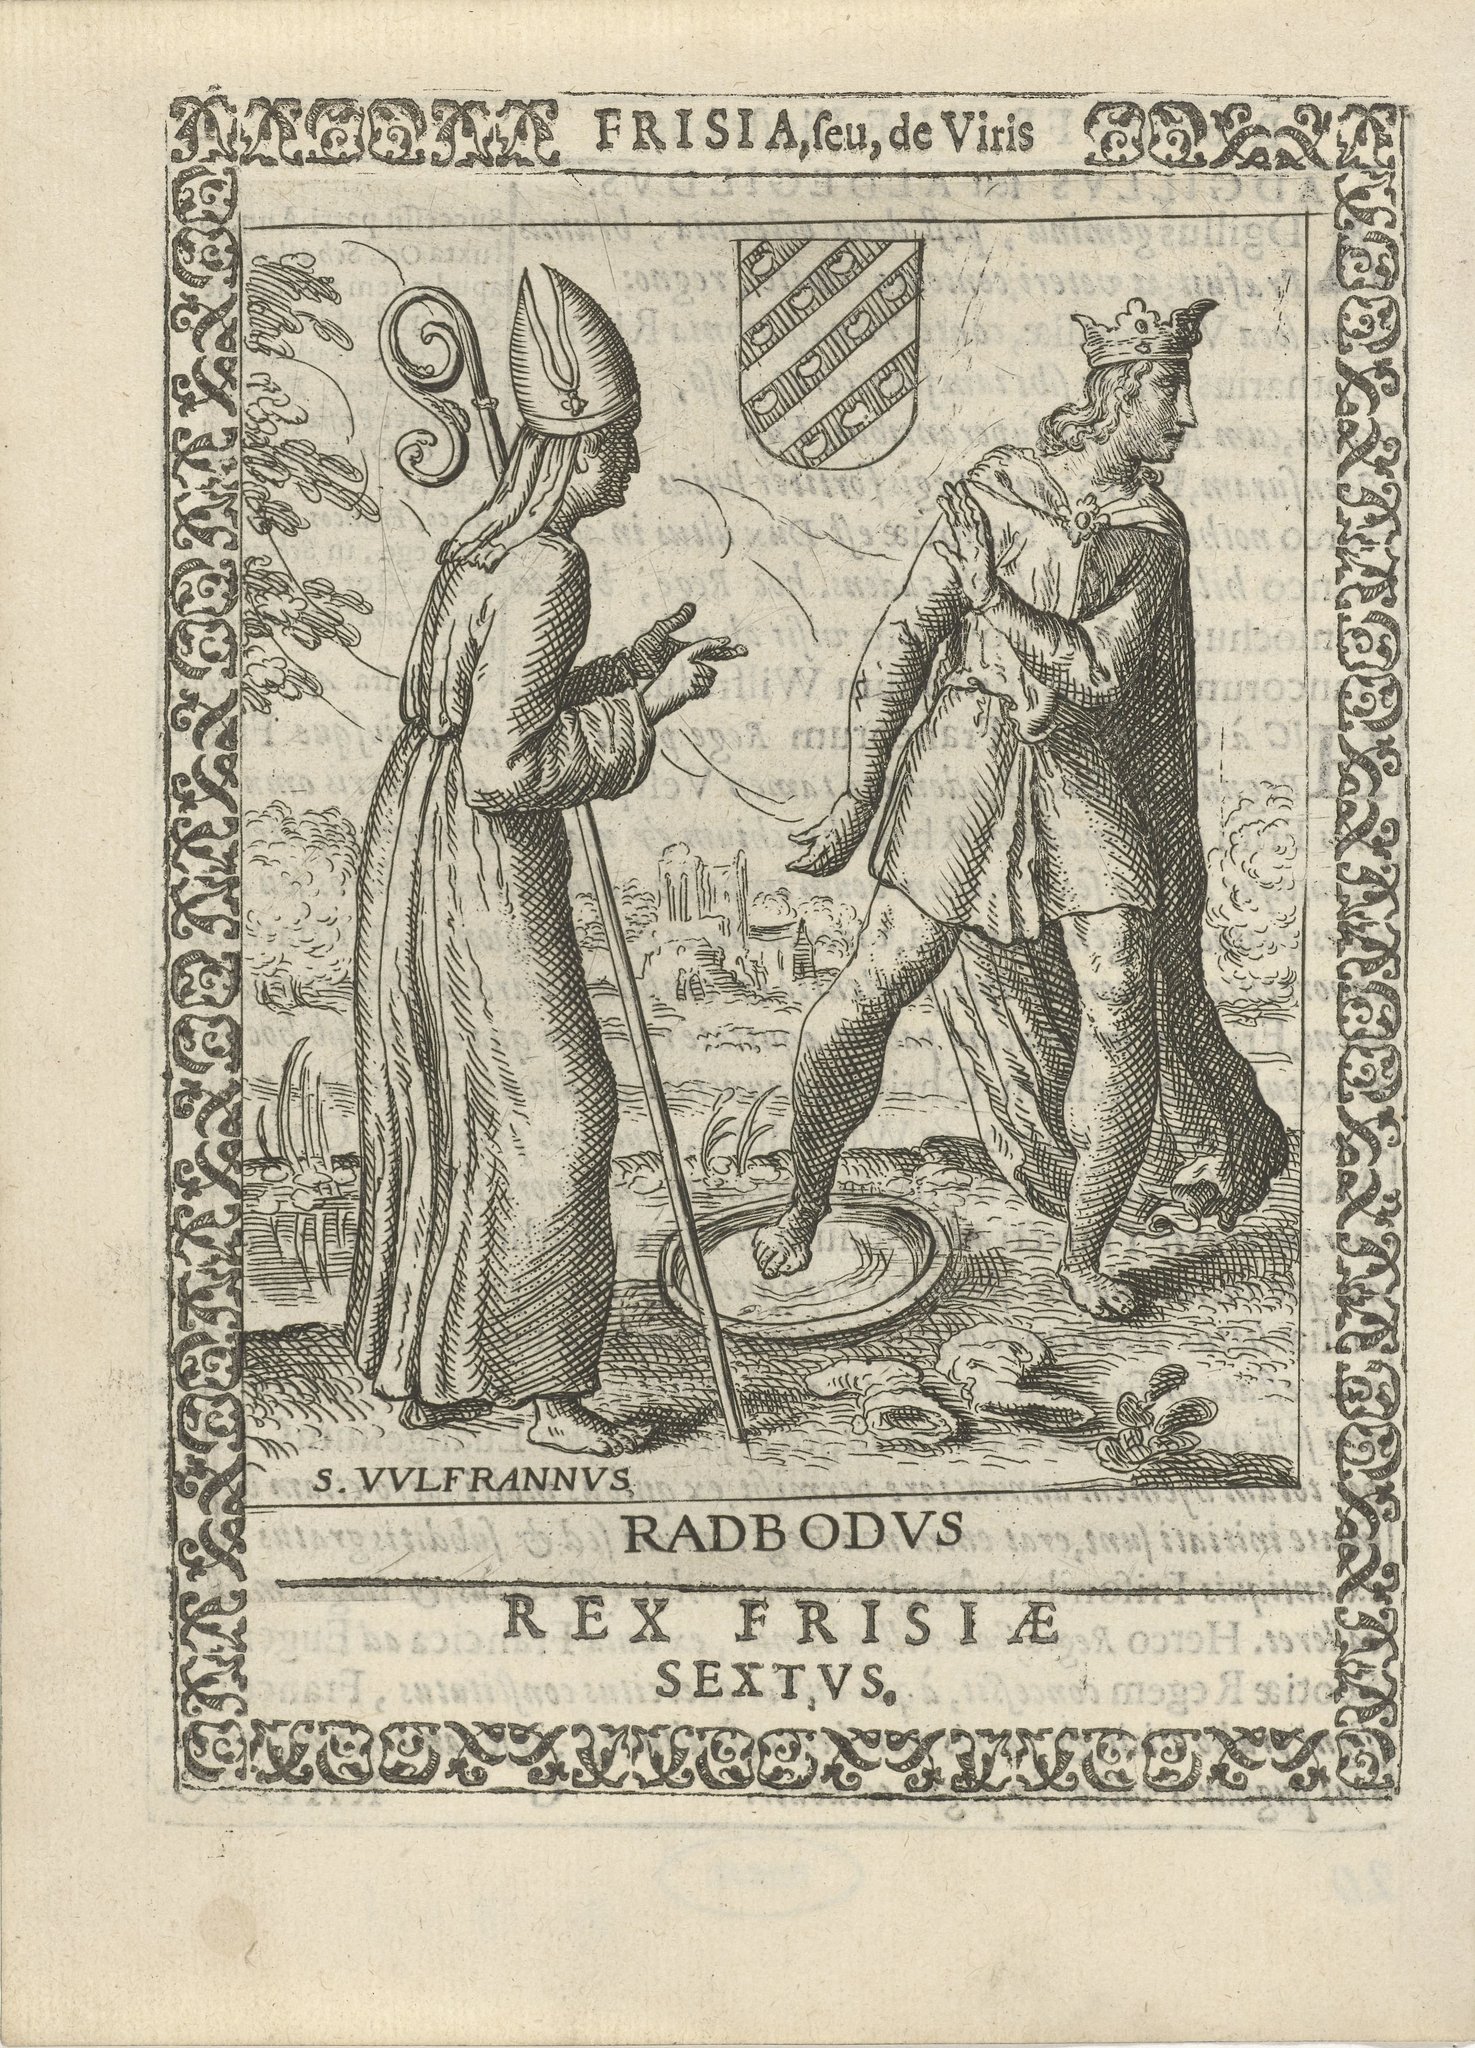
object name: print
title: Frisia, sev, de Viris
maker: pieter feddes van harlingen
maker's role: painter, print maker, publisher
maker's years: 1586-1623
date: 1618-1620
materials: paper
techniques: etching, letterpress printing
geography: friesland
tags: ruler, sovereign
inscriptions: collector's mark: Lugt 2228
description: Radbod, zesde koning der Friezen, weigert zich te laten dopen. In een ornamentale omlijsting. Illustratie, met tekst op achterzijde, afkomstig uit het boek: Frisia seu de viris rebusque Frisiae illustribus libri duo.